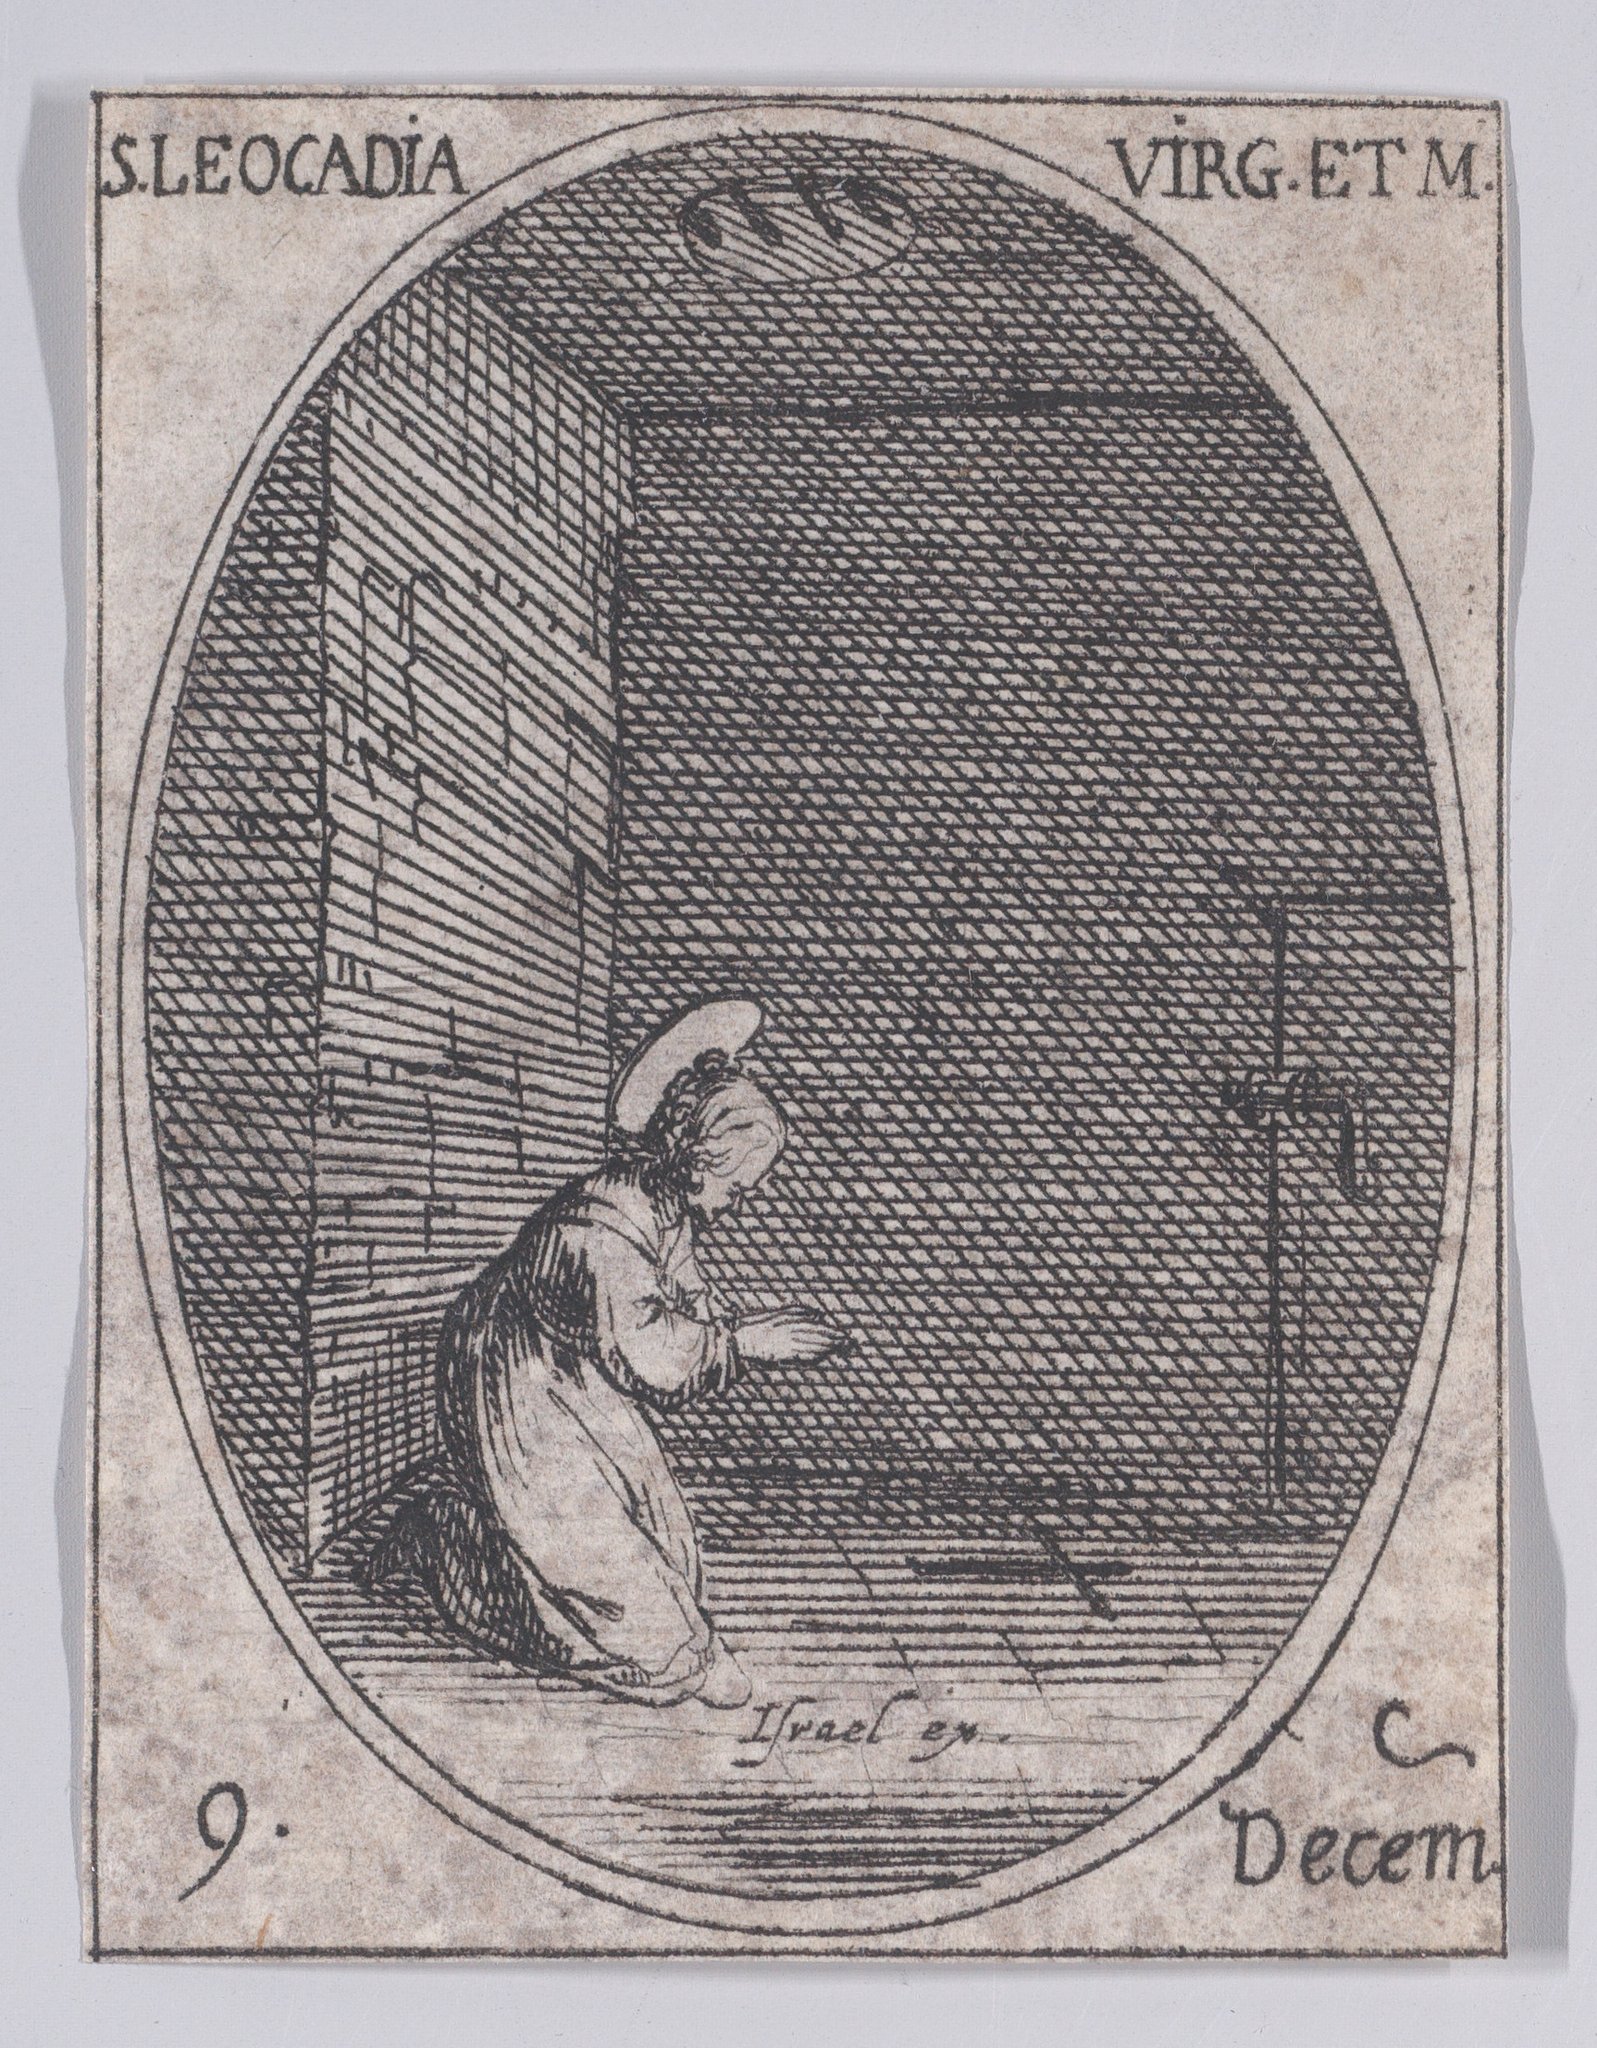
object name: print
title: Ste. Léocadie, vierge et martyre (St. Leocadia, Virgin and Martyr), December 9th, from "Les Images De Tous Les Saincts et Saintes de L'Année" (Images of All of the Saints and Religious Events of the Year)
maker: jacques callot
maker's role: artist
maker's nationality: french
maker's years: 1592-1635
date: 1636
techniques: etching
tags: women,saints